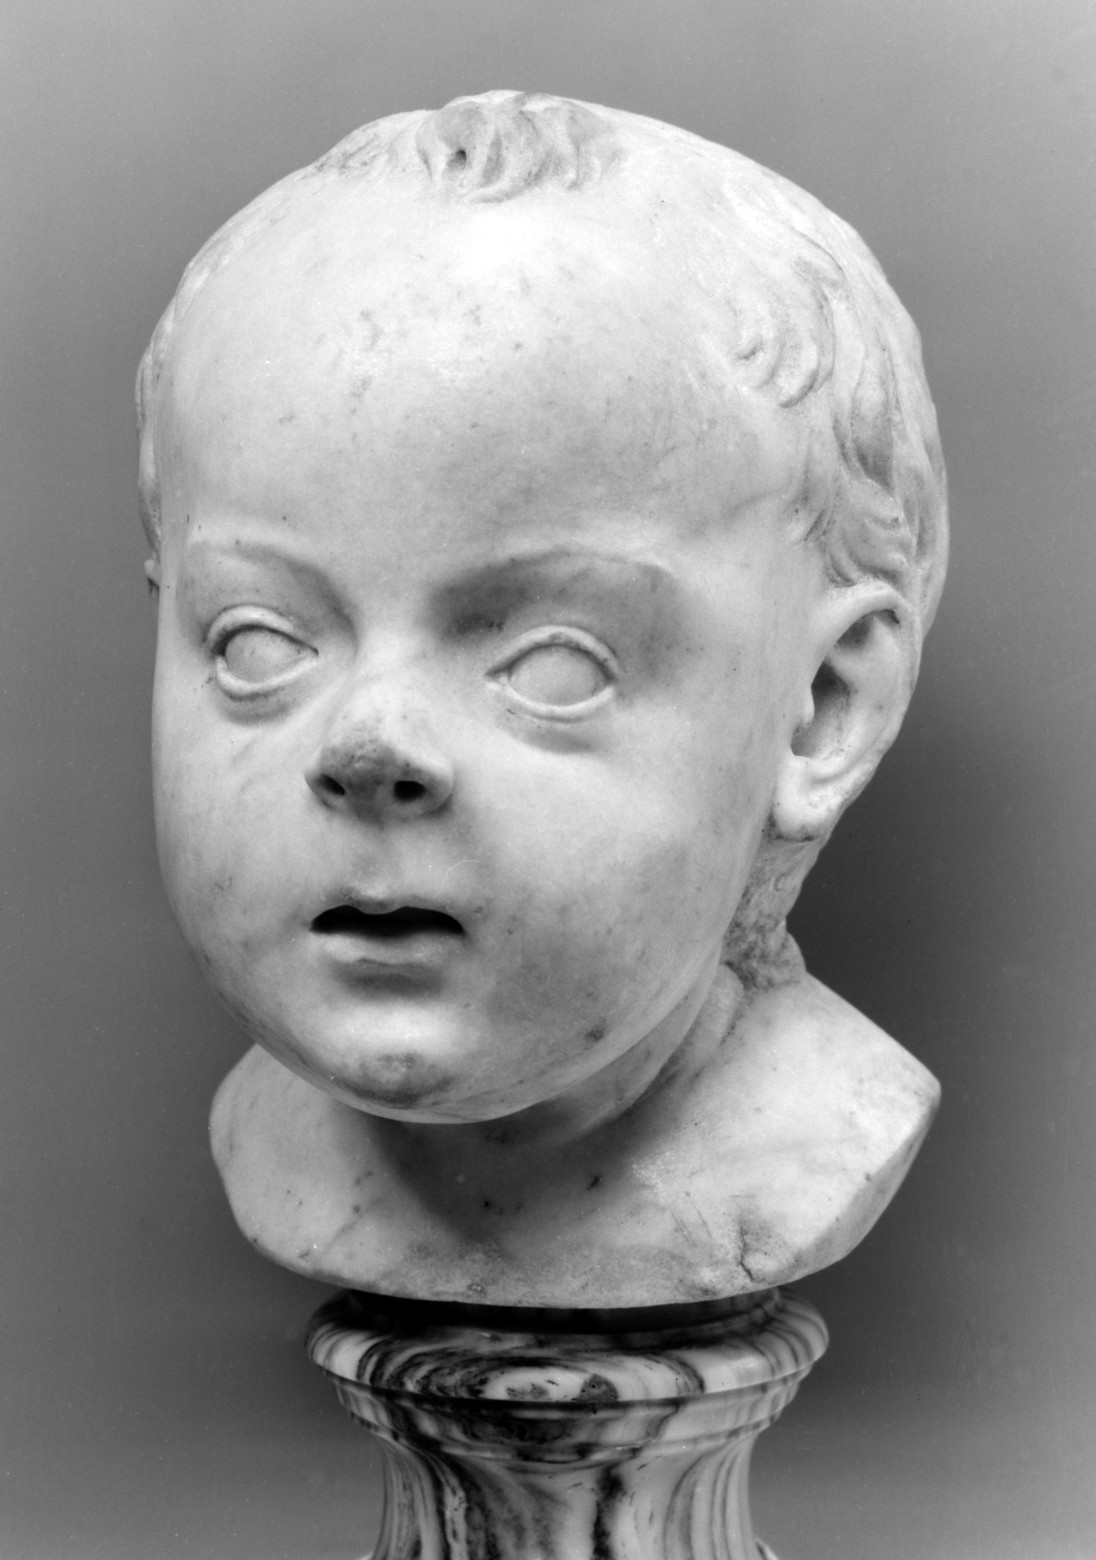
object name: bust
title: Head of a child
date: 1467-1500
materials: marble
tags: heads